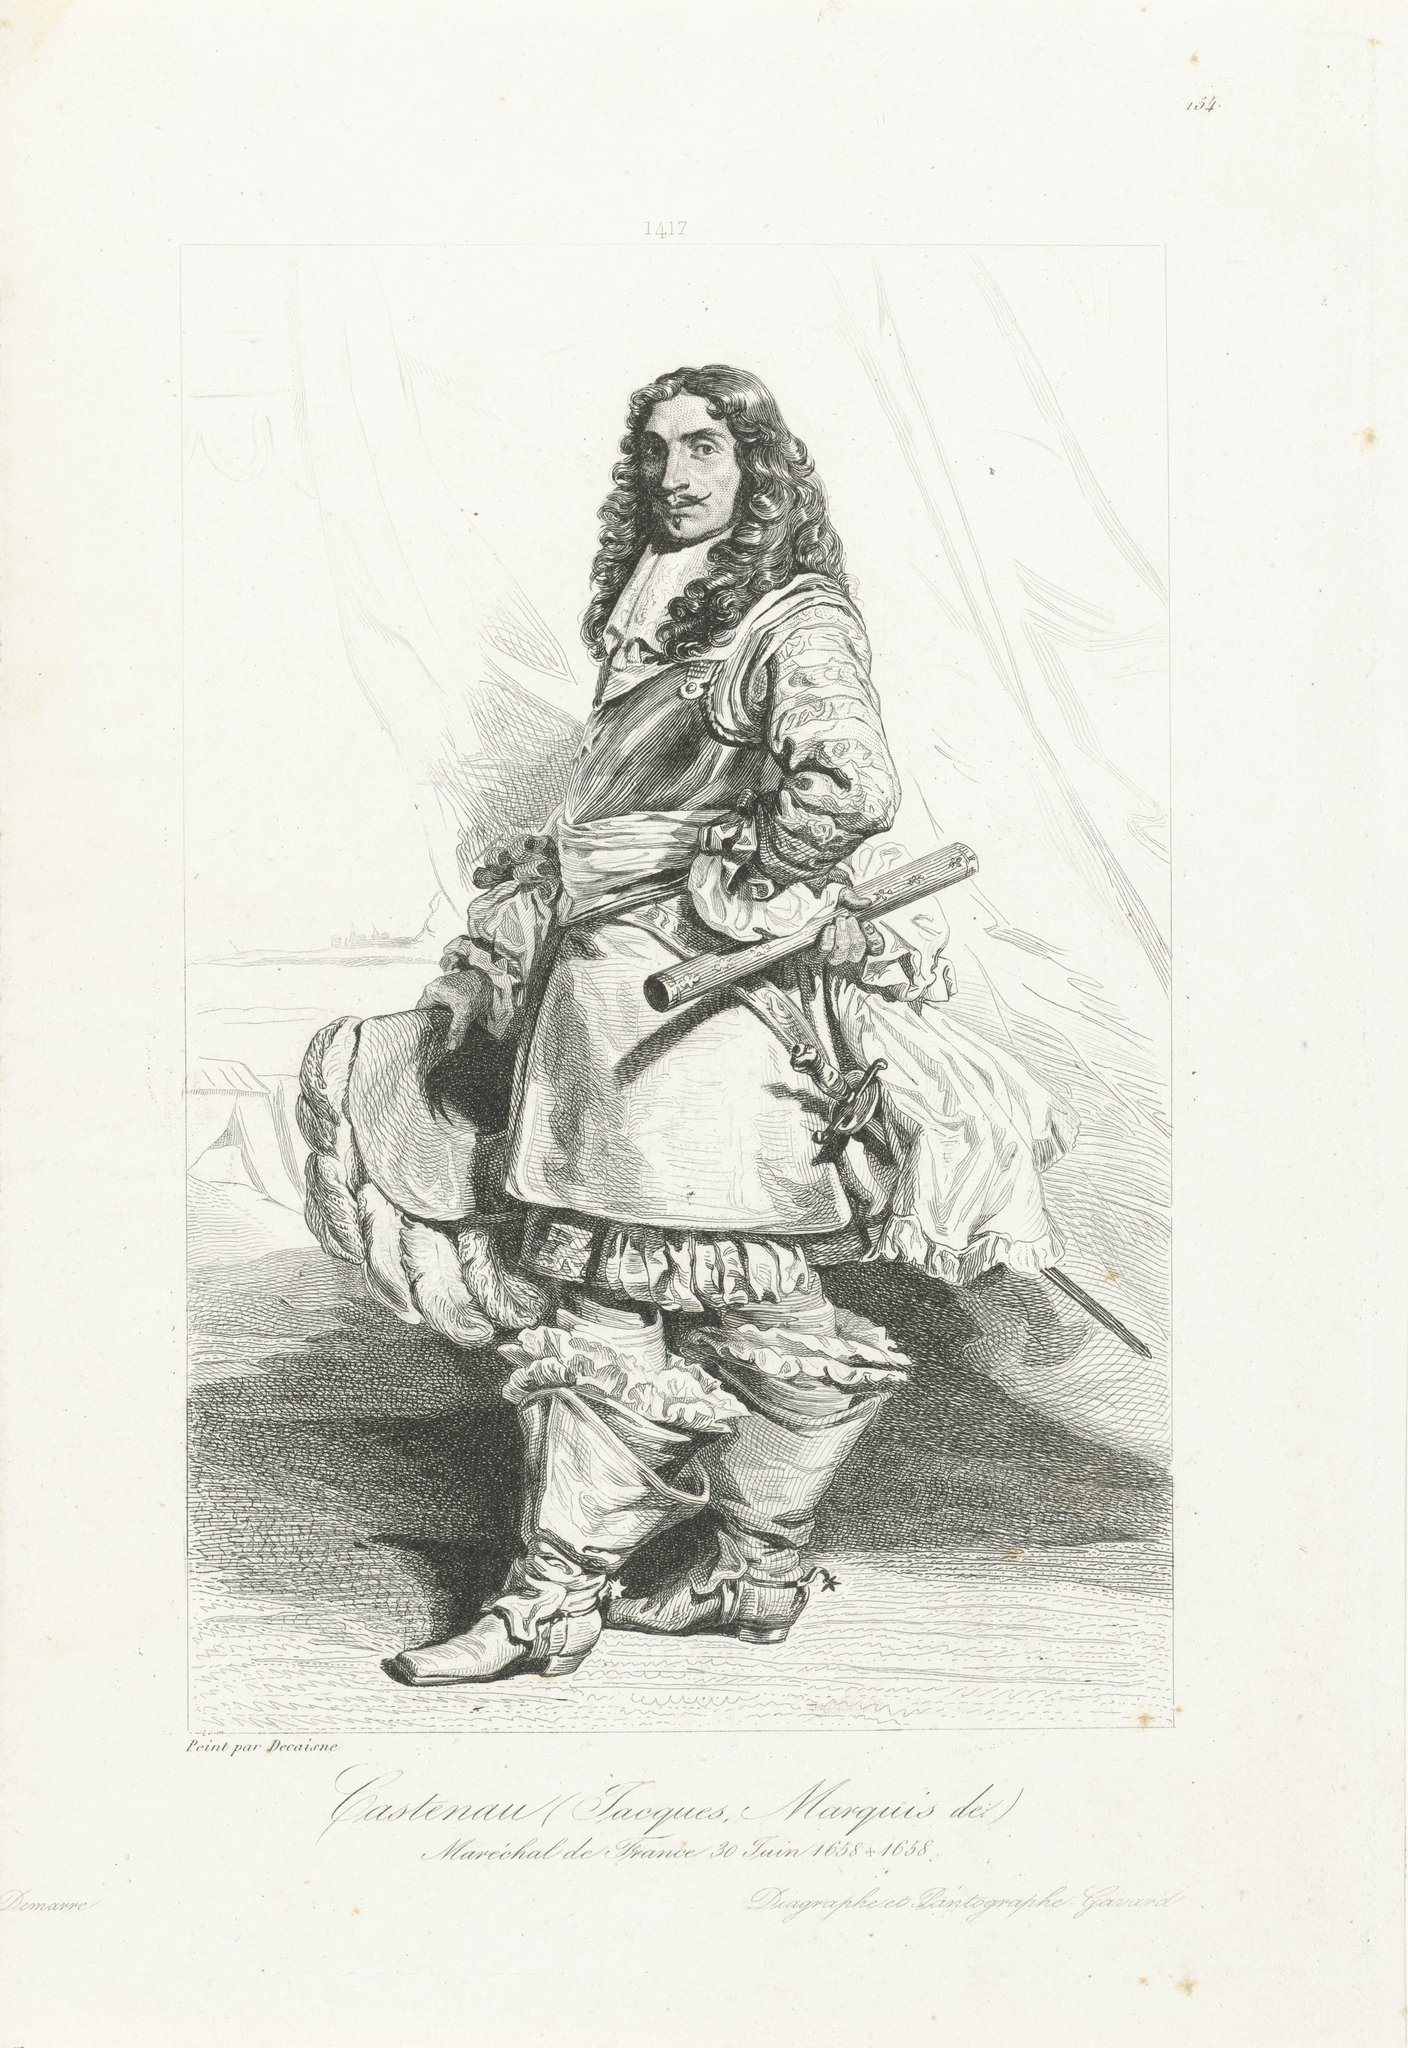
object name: book illustration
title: Portret van Jacques II de Castelnau-Mauvissière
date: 1837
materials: paper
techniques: engraving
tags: maarschalk, jacques de castelnau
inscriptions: collector's mark: Lugt 2228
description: Prent gebruikt in: Janin, M. Jules. Galleries historique de Versailles. Parijs: s.n. 1837.